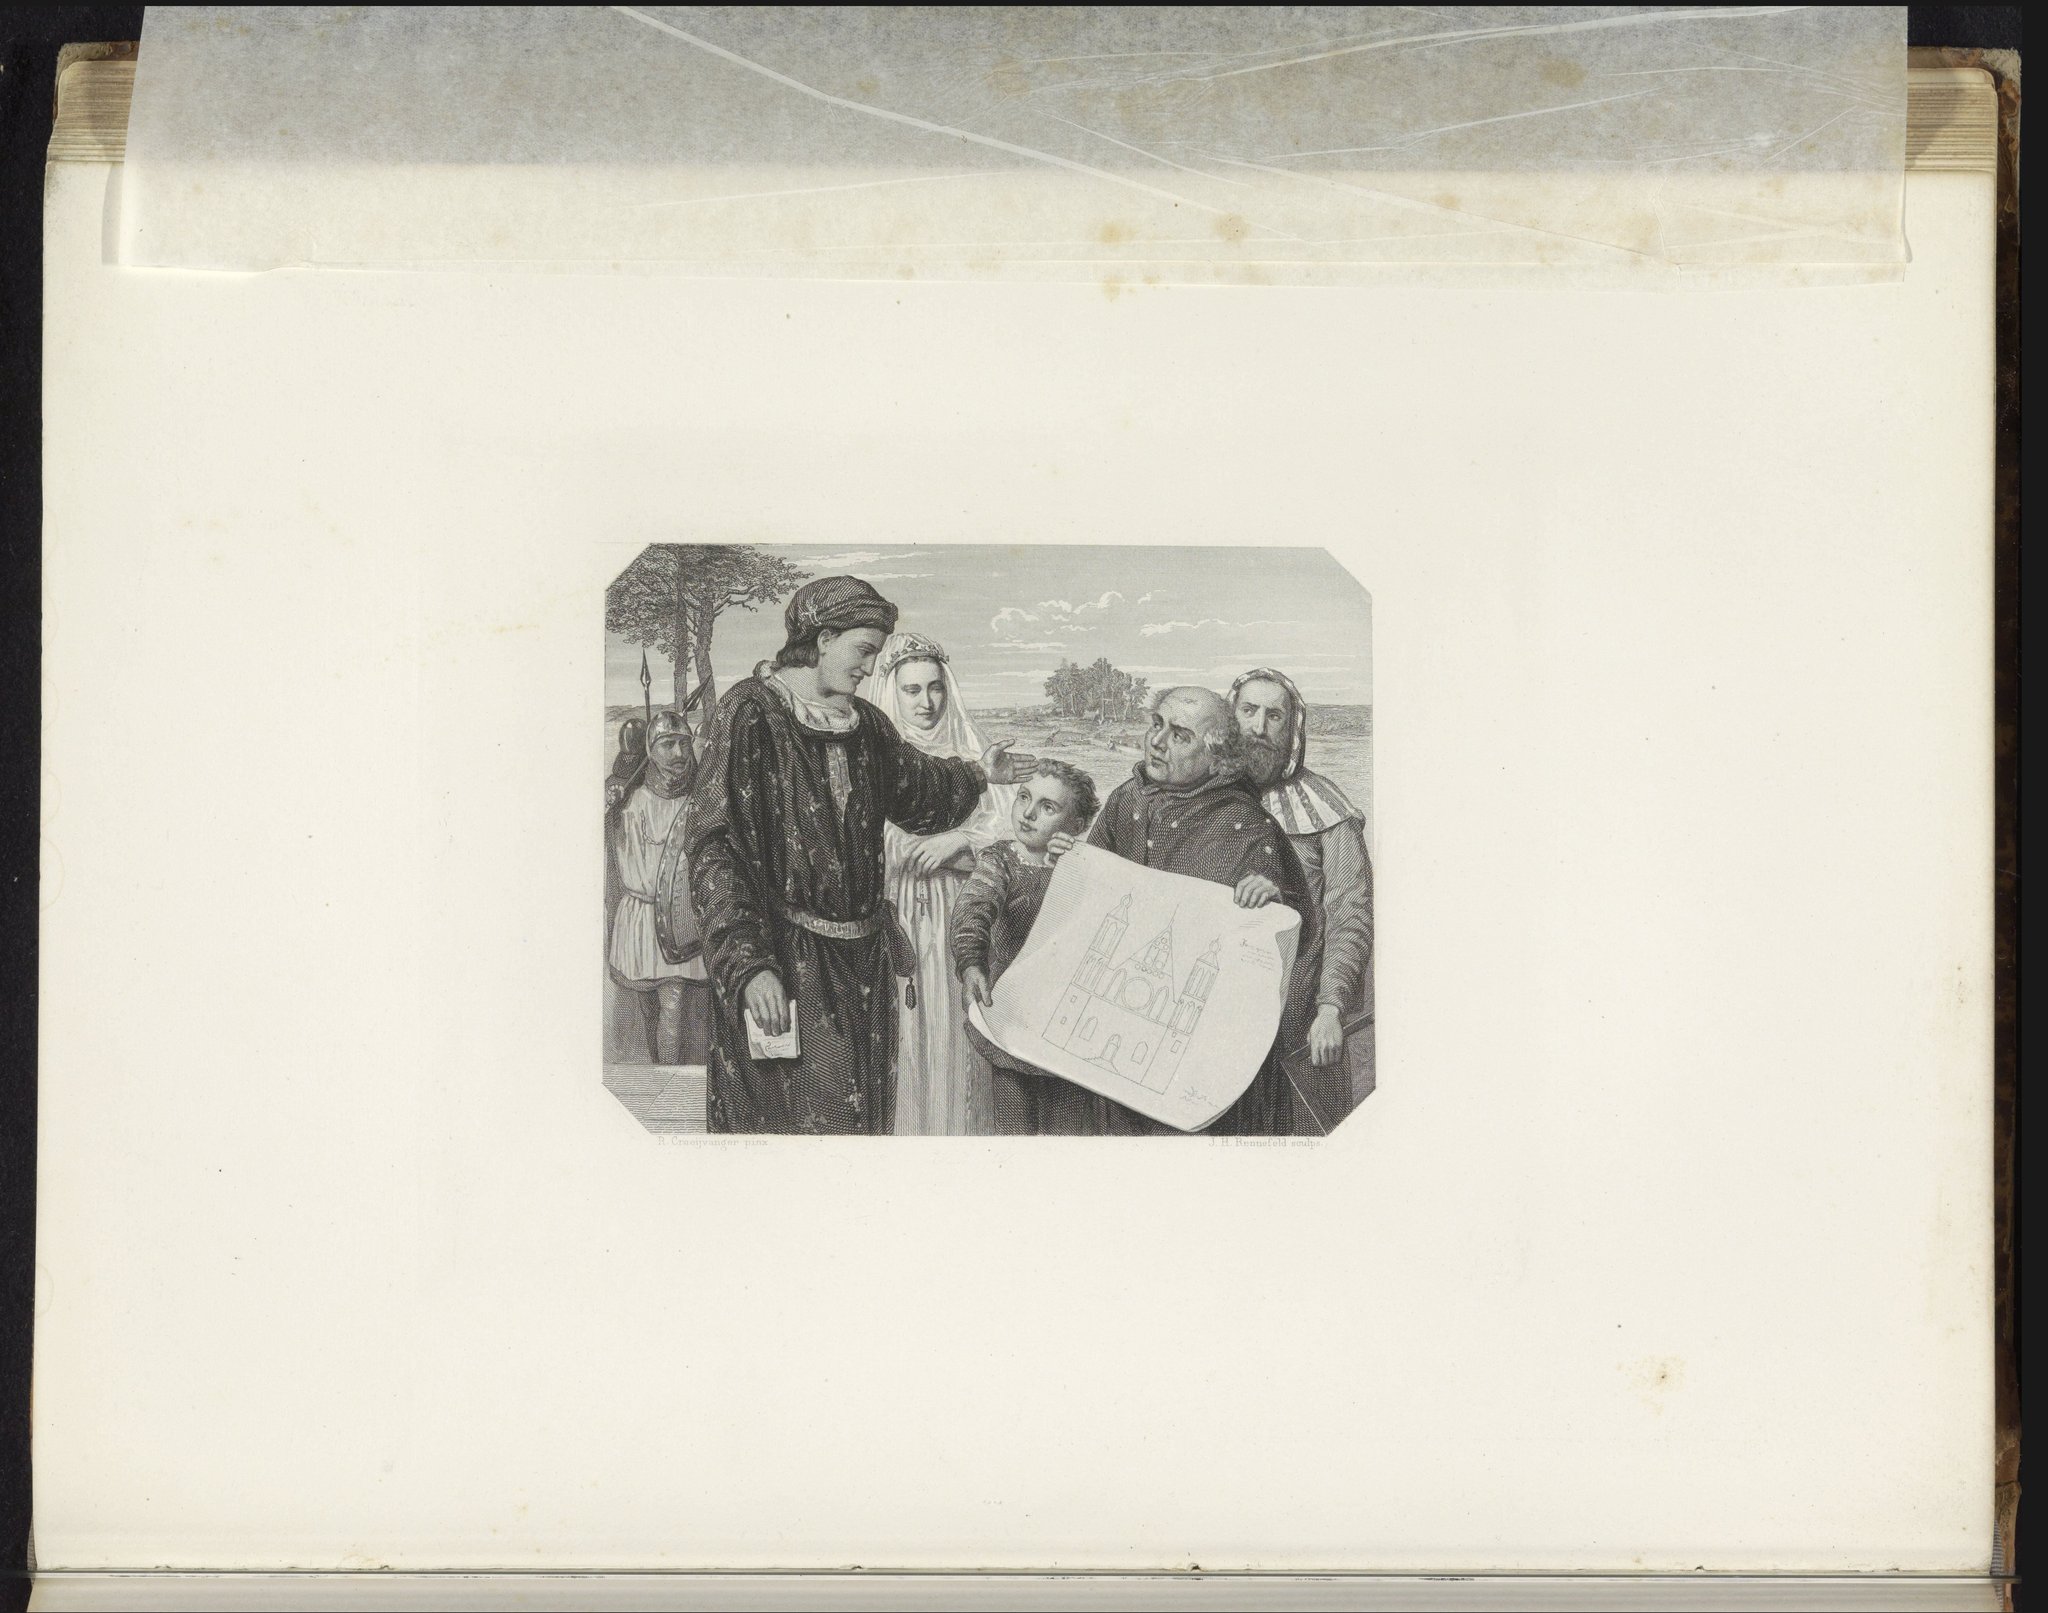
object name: print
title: Willem II sticht het Binnenhof te 's-Gravenhage, ca. 1250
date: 1865-1870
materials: paper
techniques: engraving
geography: netherlands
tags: earl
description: Graaf Willem II van Holland bekijkt een ontwerptekening van de gevel van het Binnenhof te 's-Gravenhage, ca. 1250. Onderdeel van de groep staalgravures naar de schilderijen van de Historische Galerij der Maatschappij Arti et Amicitiae.